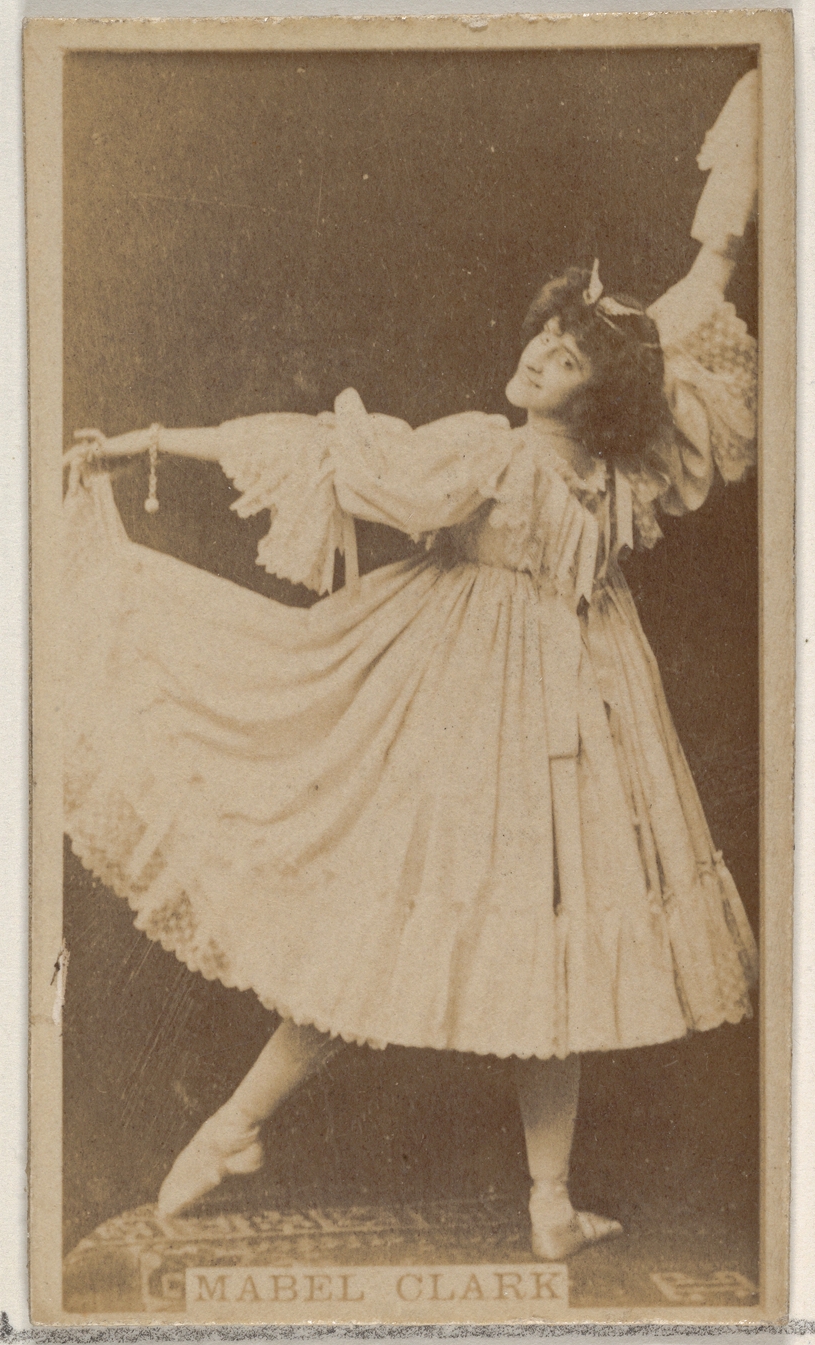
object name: photograph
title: Mabel Clark, from the Actors and Actresses series (N45, Type 8) for Virginia Brights Cigarettes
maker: allen & ginter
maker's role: publisher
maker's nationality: american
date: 1888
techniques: albumen silver print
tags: portraits,women,actresses